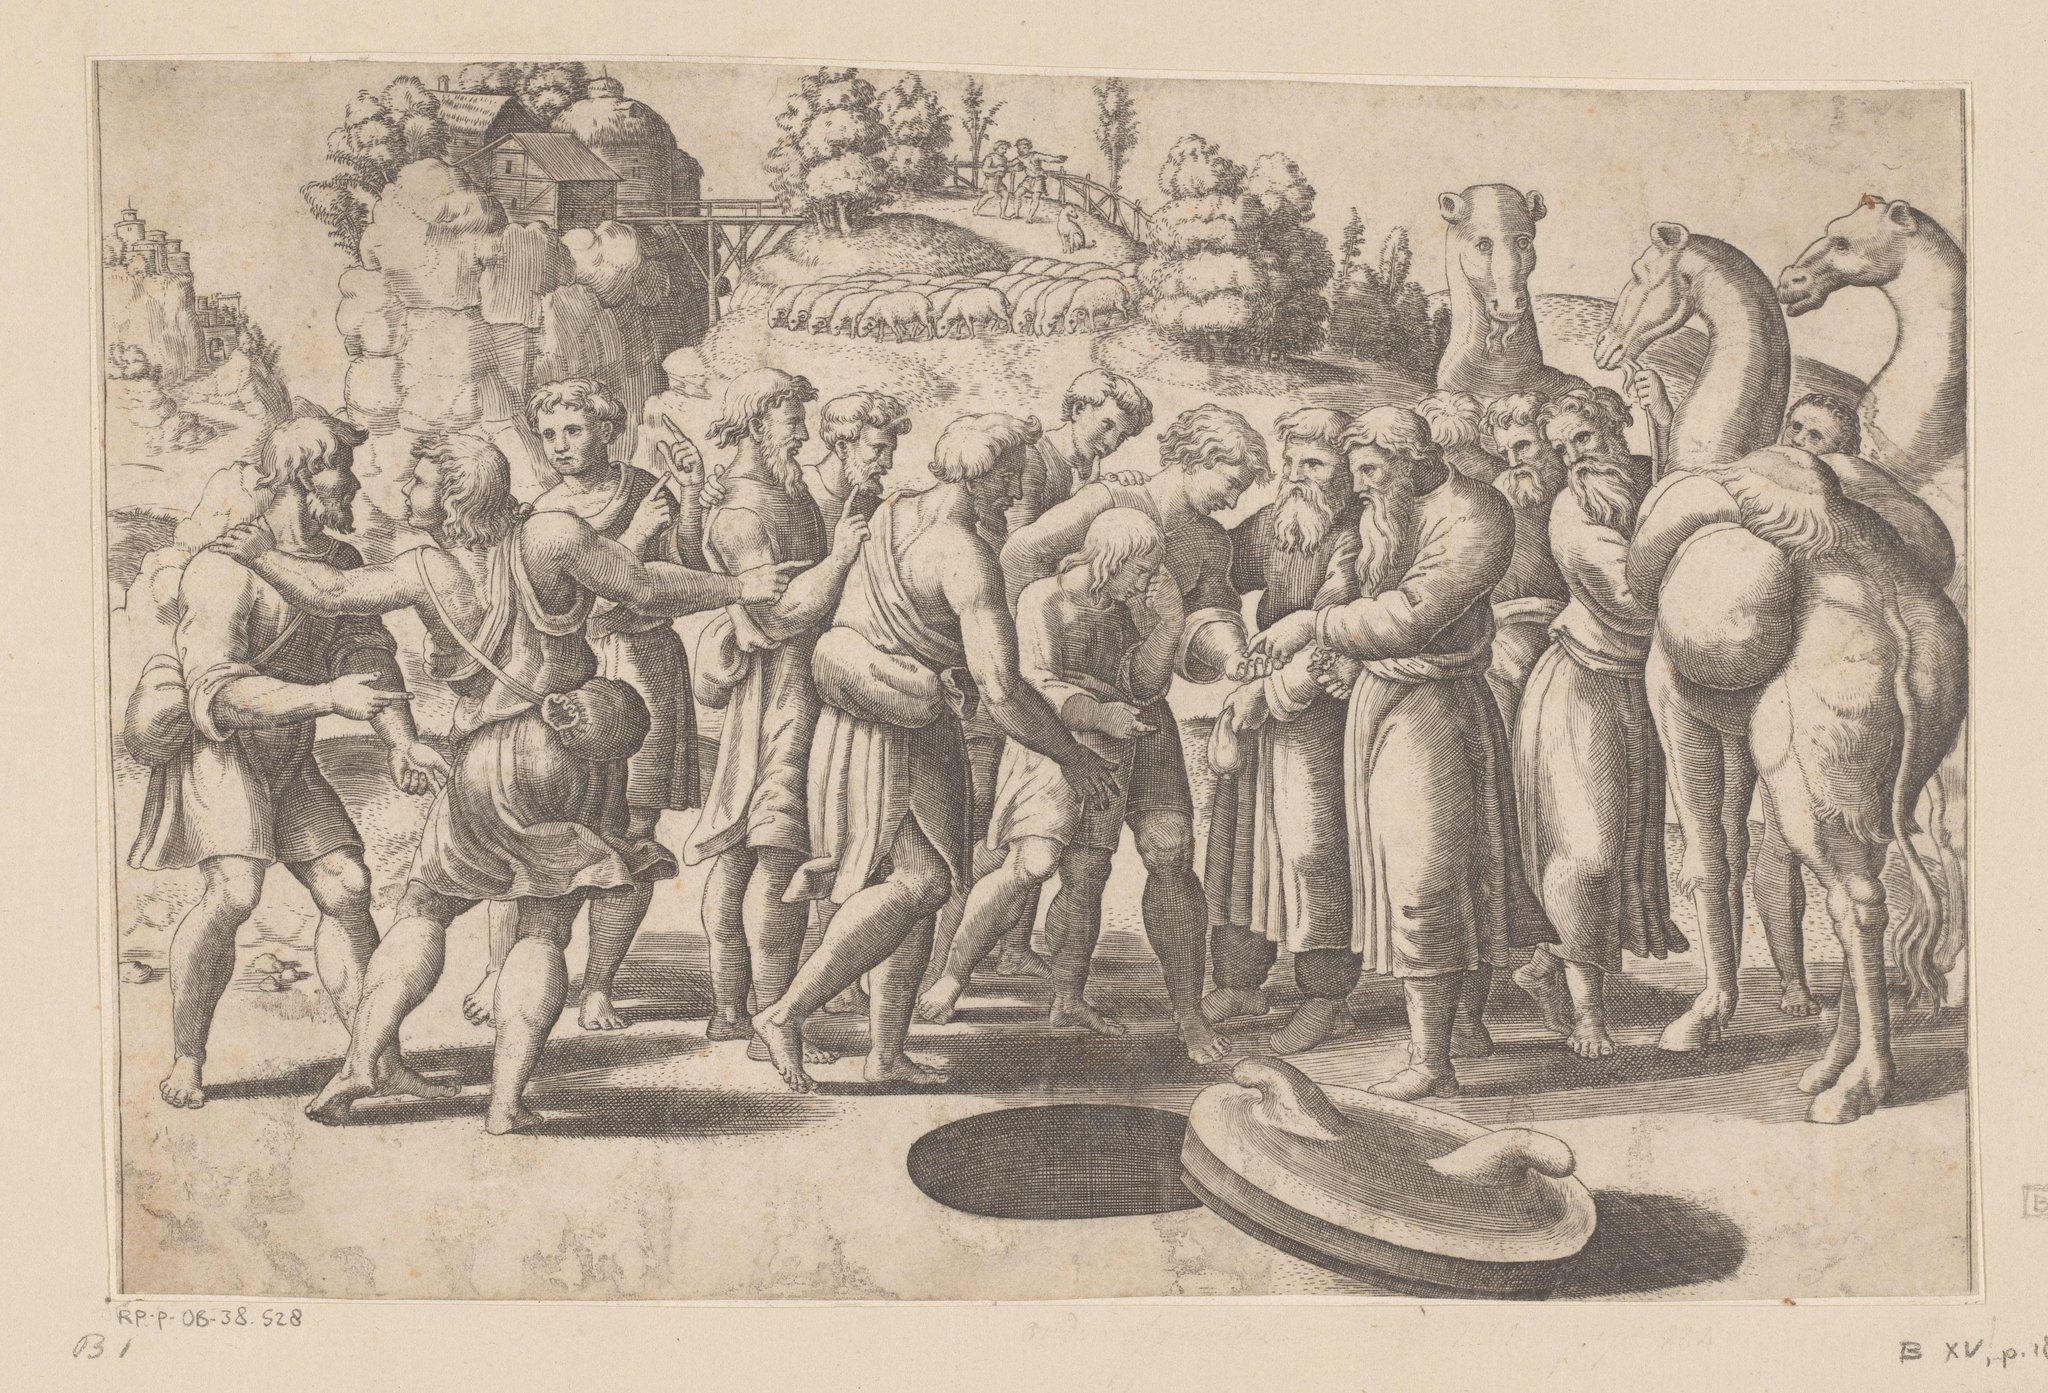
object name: print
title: Jozef door zijn broers verkocht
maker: meester van de dobbelsteen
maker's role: print maker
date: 1533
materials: paper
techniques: engraving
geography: italy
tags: city-view, and landscape with man-made constructions, hoofed animals: dromedary, joseph sold into slavery and taken to egypt (genesis 37:12-35)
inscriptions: collector's mark: Lugt 240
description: In het midden naast een put staat Jozef. Links staan zijn broers en rechts de Ismaëlitische kooplieden aan wie Jozef werd verkocht. Rechts drie dromedarissen en op de achtergrond een landschap.